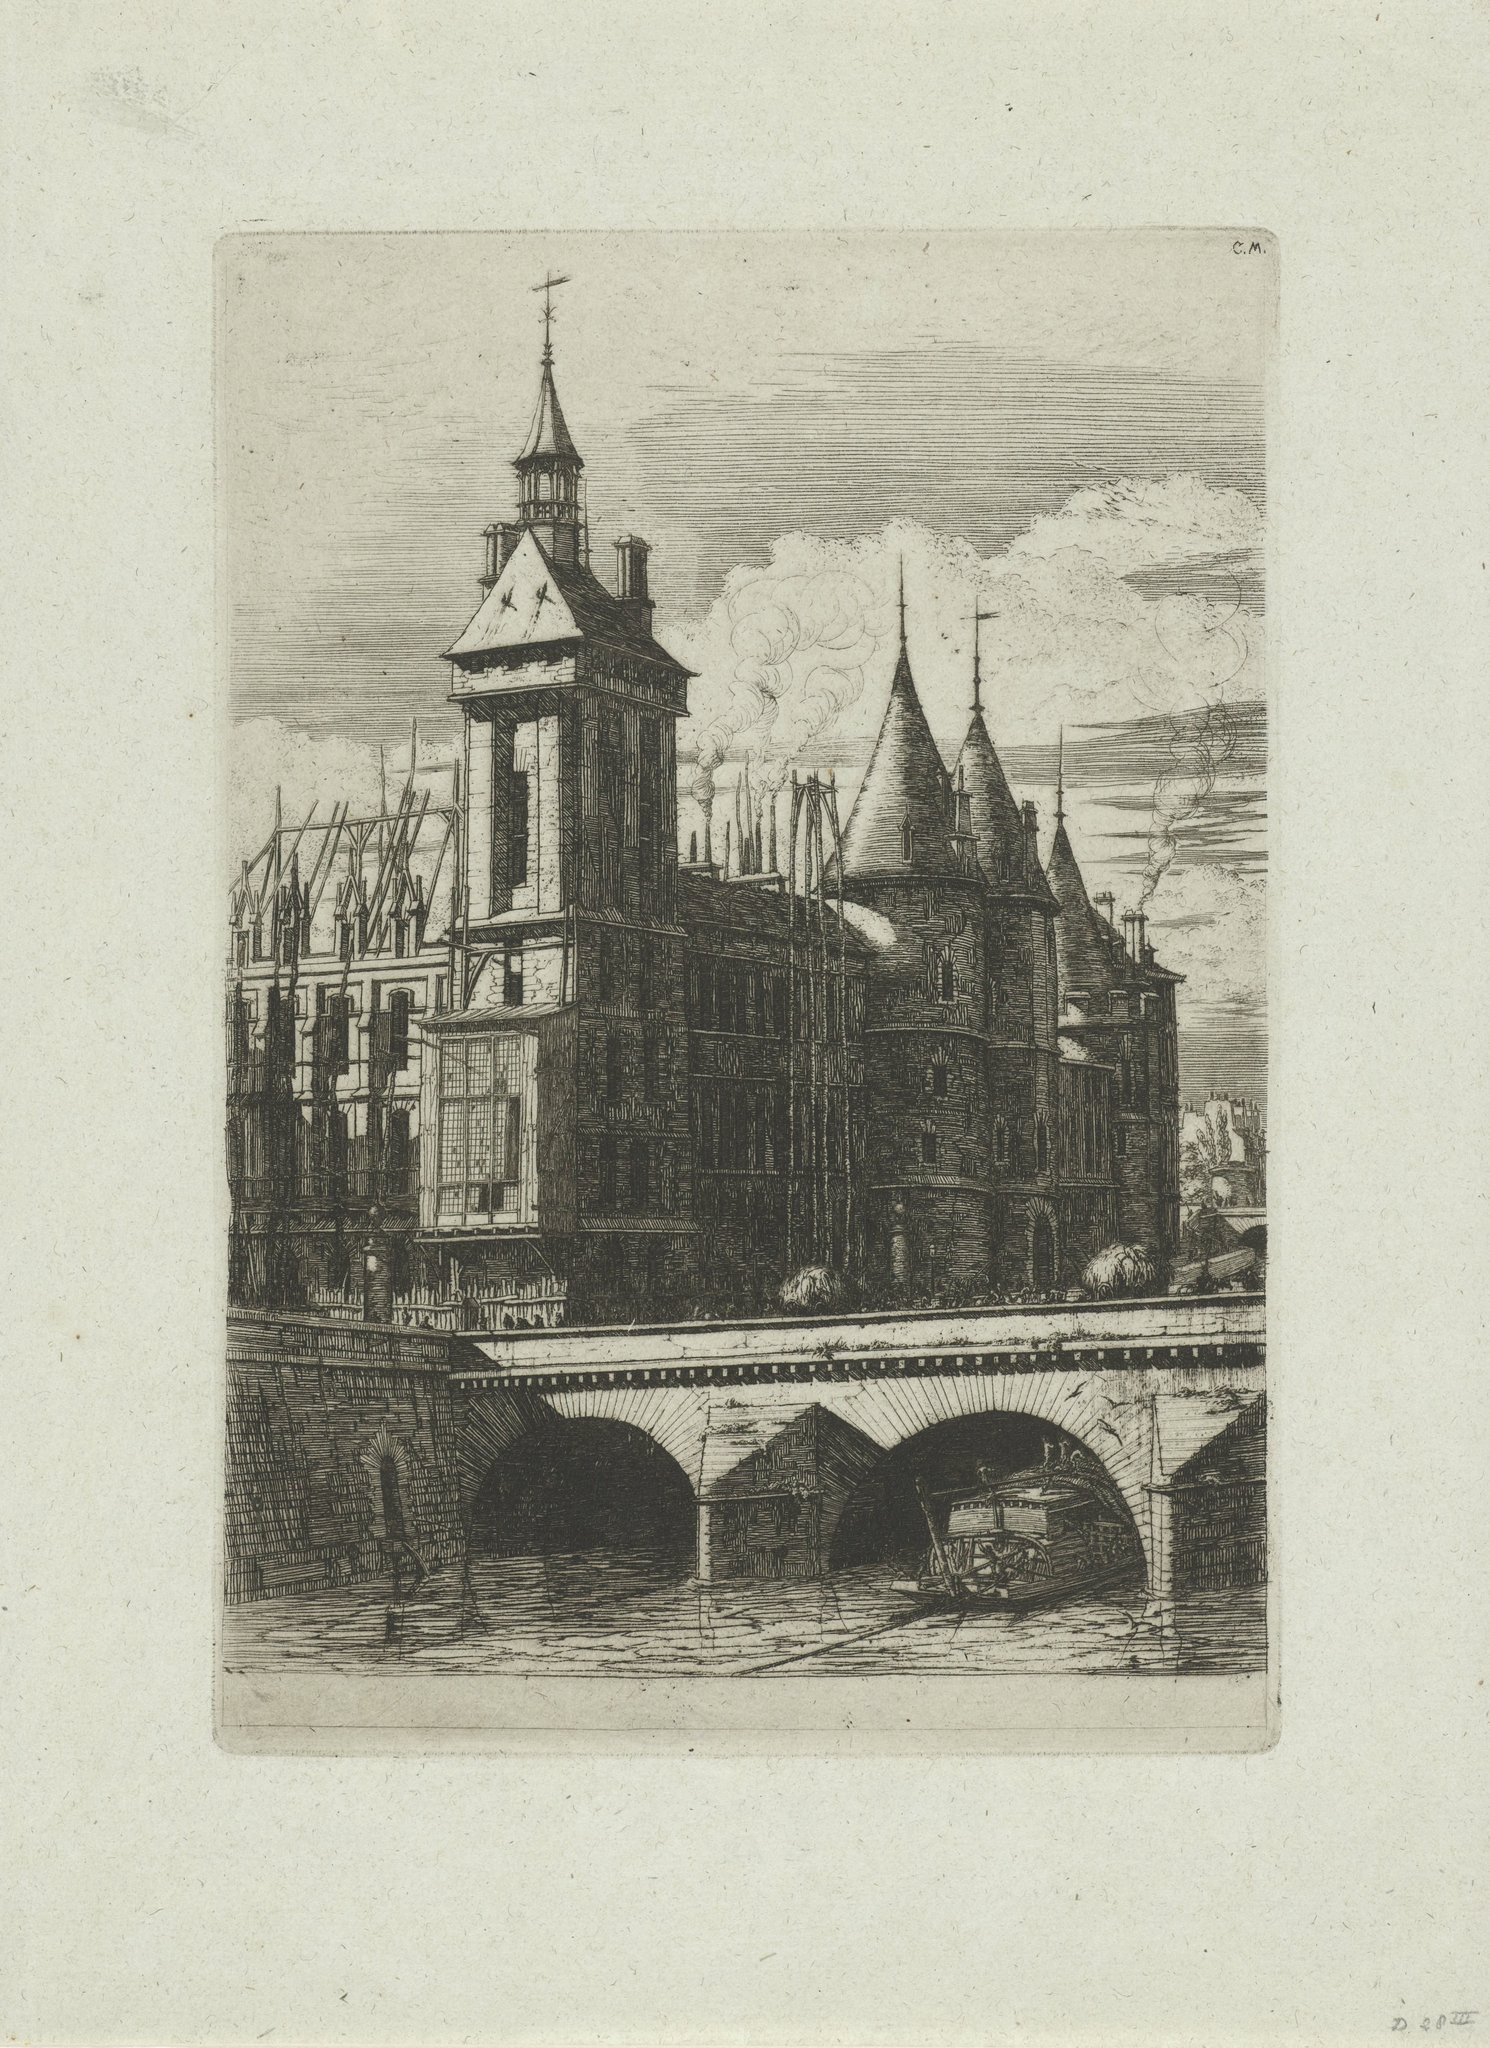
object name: print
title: Toren met uurwerk op hoek van Palais de Justice in Parijs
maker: charles meryon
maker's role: print maker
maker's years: 1821-1868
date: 1852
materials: paper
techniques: etching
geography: paris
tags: palais de justice, tour de l'horloge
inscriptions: collector's mark: Lugt 2760, collector's mark: Lugt 2228, collector's mark: Lugt 1298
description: Het Palais de Justice, met op de hoek de toren met een uurwerk, staat in de steigers tijdens een verbouwing in 1852 in Parijs. Op de voorgrond ligt de Pont-au-Change over de Seine. Het is druk op de brug waar kleine figuren lopen en hoog beladen wagens rijden.